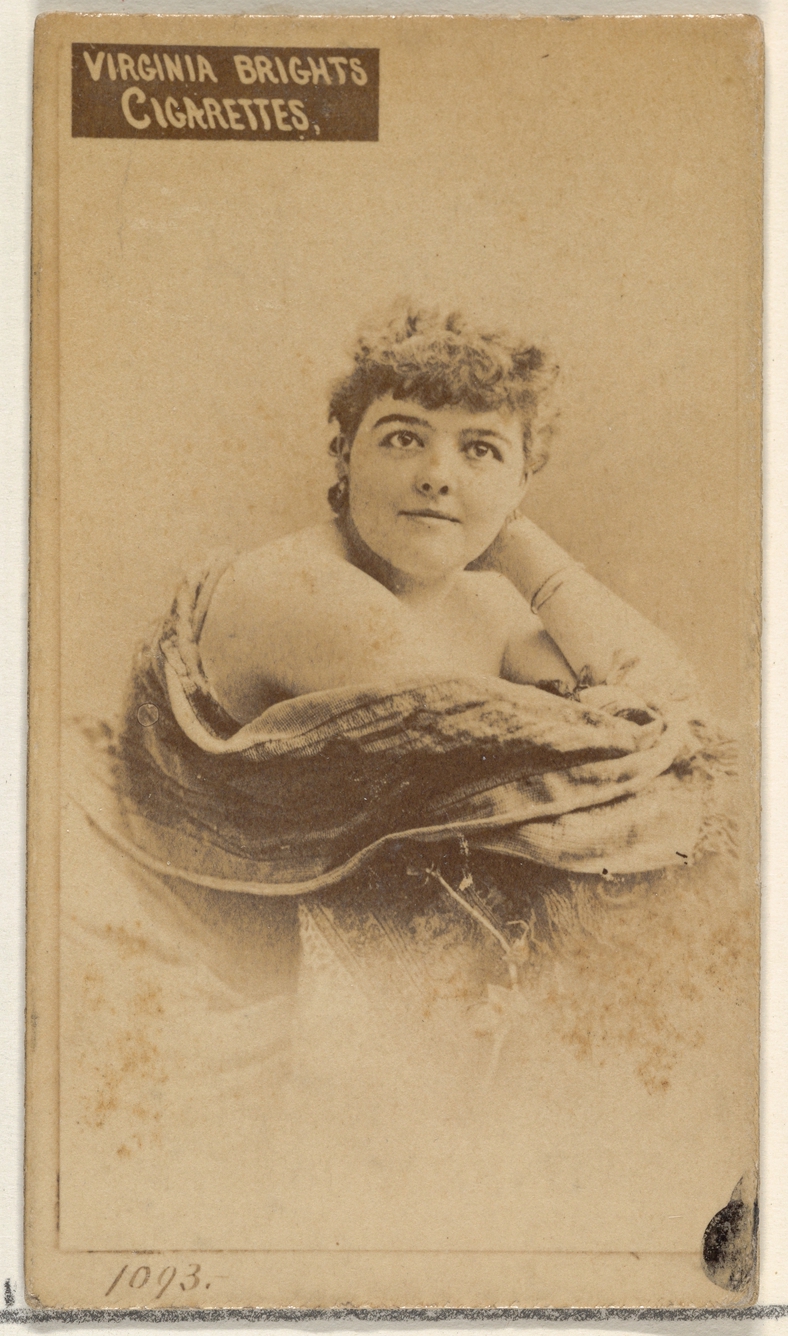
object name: photograph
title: Card 1093, from the Actors and Actresses series (N45, Type 2) for Virginia Brights Cigarettes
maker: allen & ginter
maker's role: publisher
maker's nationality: american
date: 1888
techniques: albumen silver print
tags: portraits,women,actresses